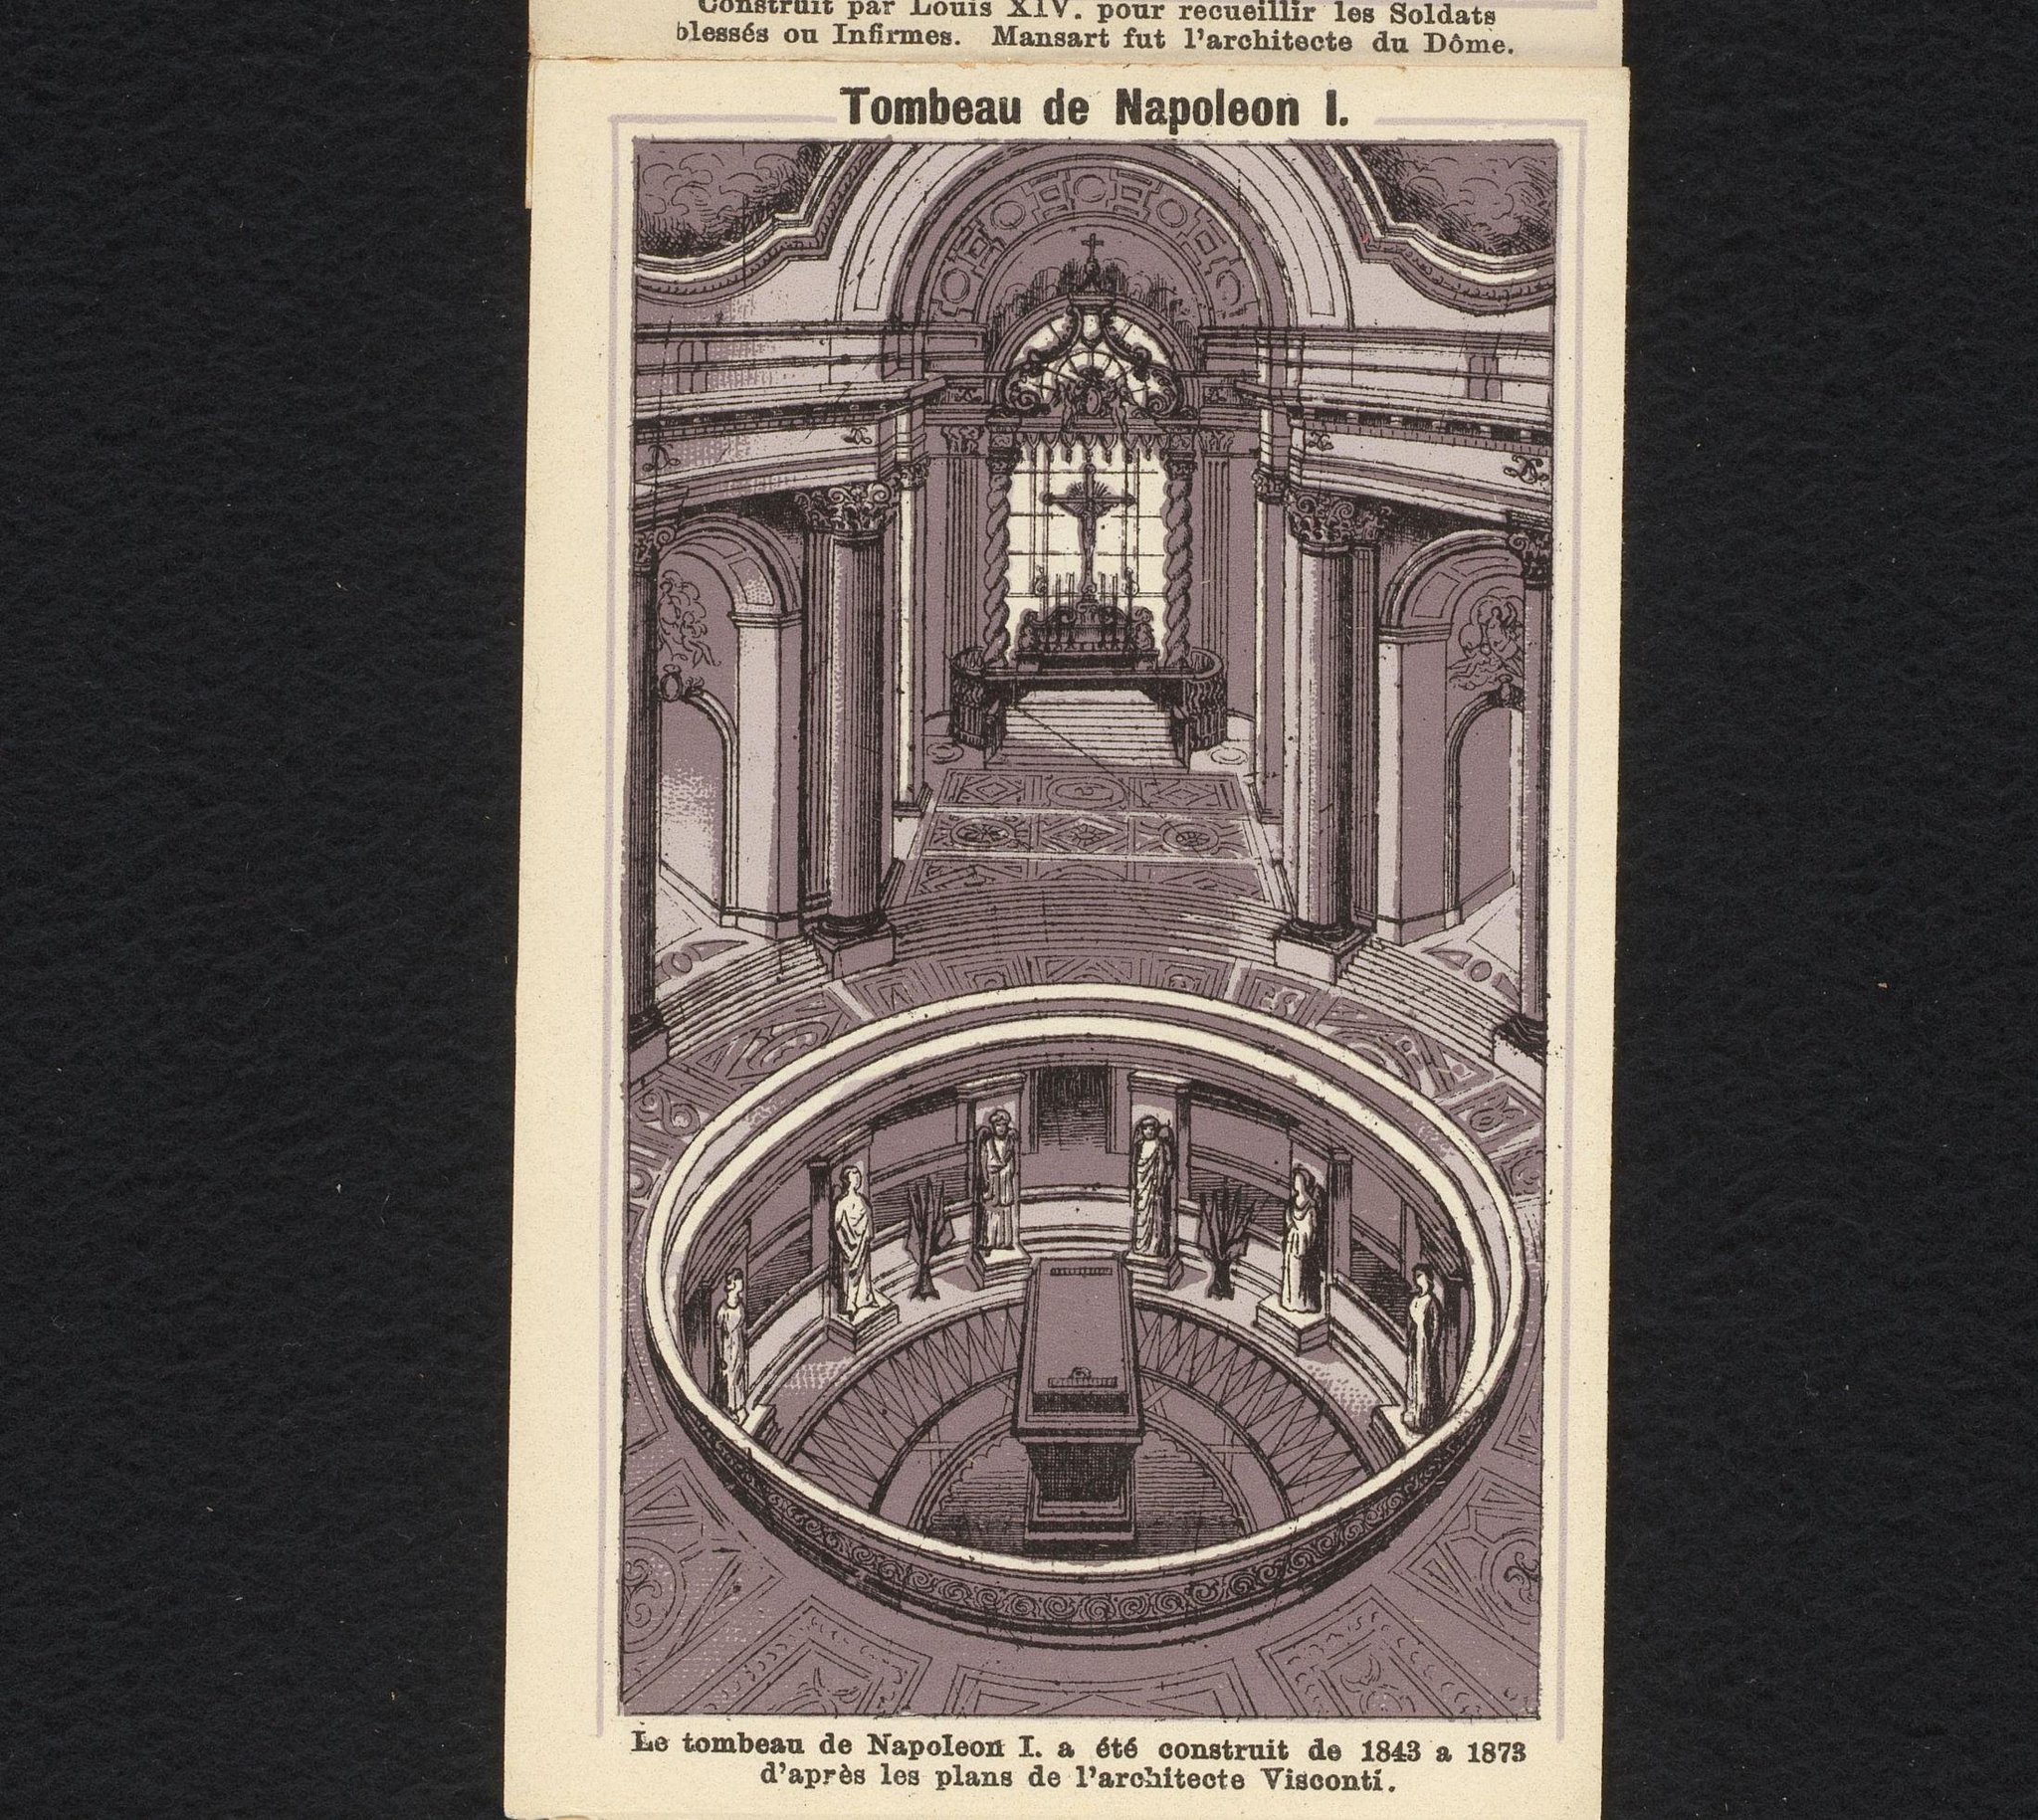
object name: print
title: Tombeau de Napoleon I. Le tombeau de Napoleon a été construit de 1843 à 1873 d'après les plans de l'architecte Visconti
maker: Anonymous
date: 1890-1910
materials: cardboard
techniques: lithograph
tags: grave, tomb, interior ~ representation of a building